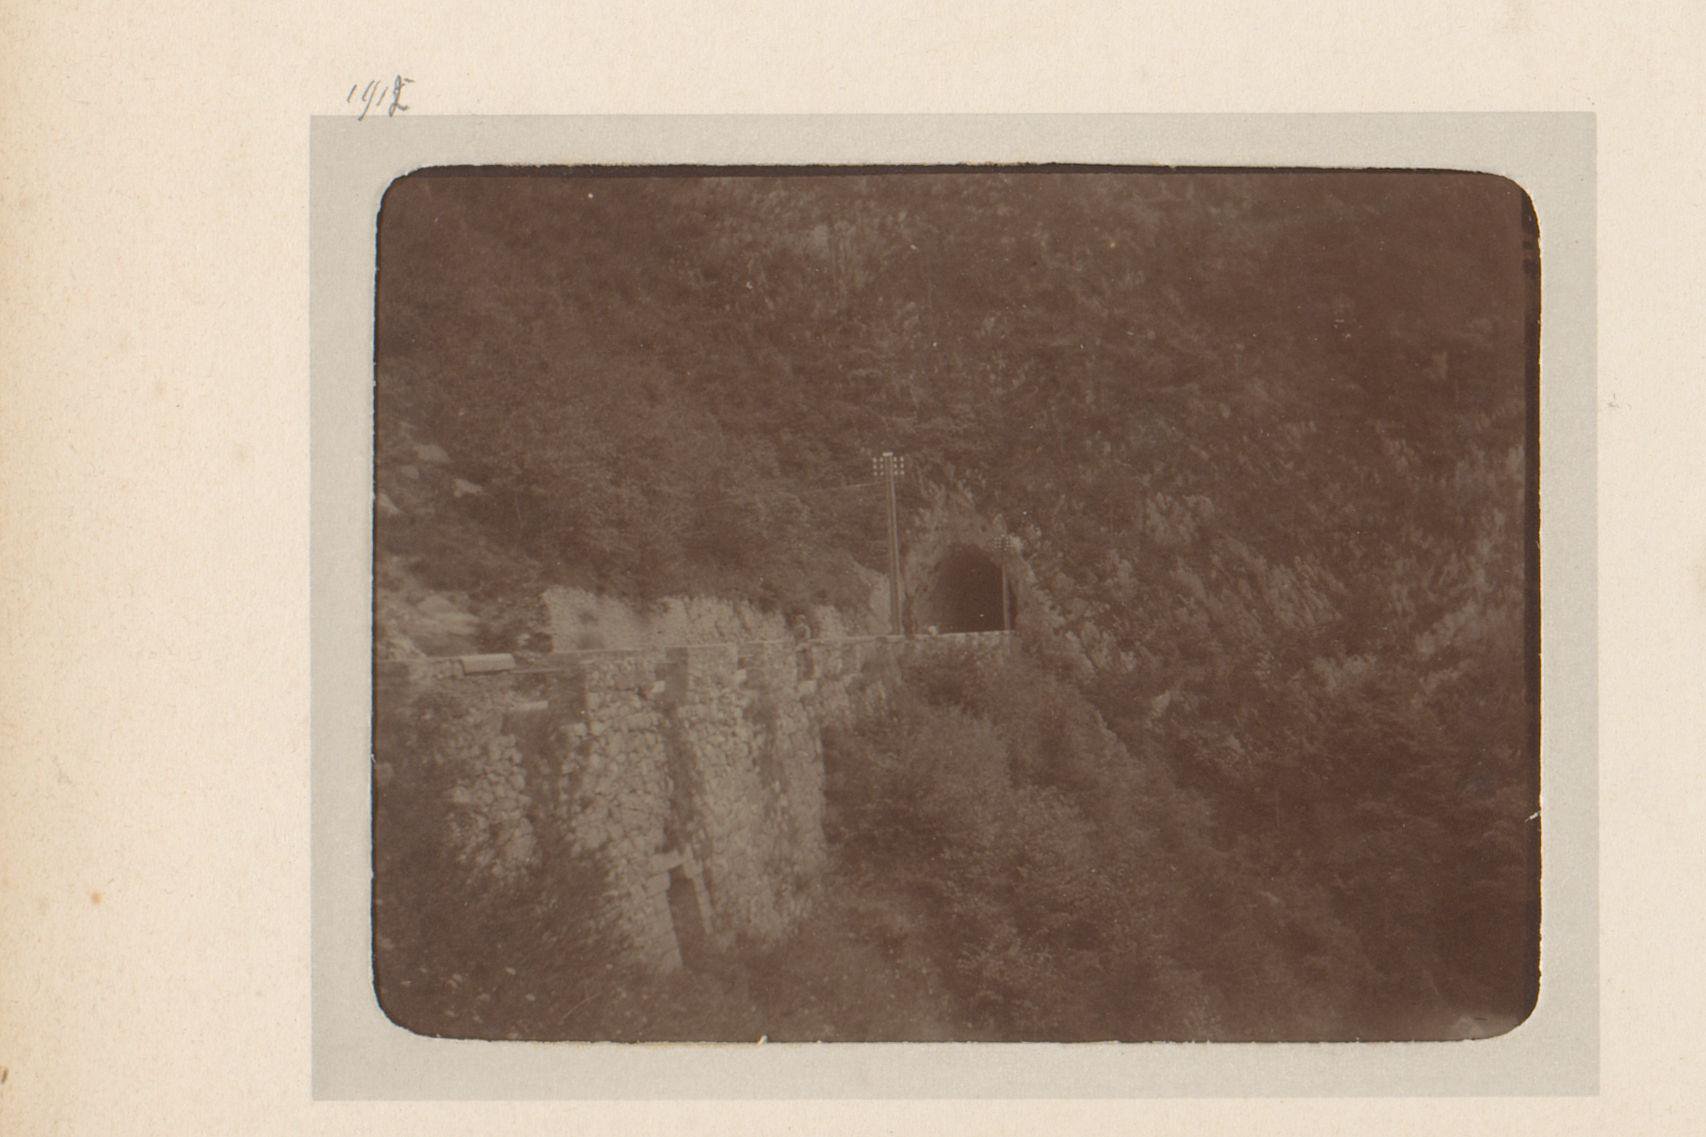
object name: photograph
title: Berglandschap met tunnel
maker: liesbeth overhoff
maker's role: fotograaf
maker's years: 1895-1969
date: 1912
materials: paper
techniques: gelatin silver print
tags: mountain climbing, mountaineering, underground road, tunnel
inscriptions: inscription: ‘1912’